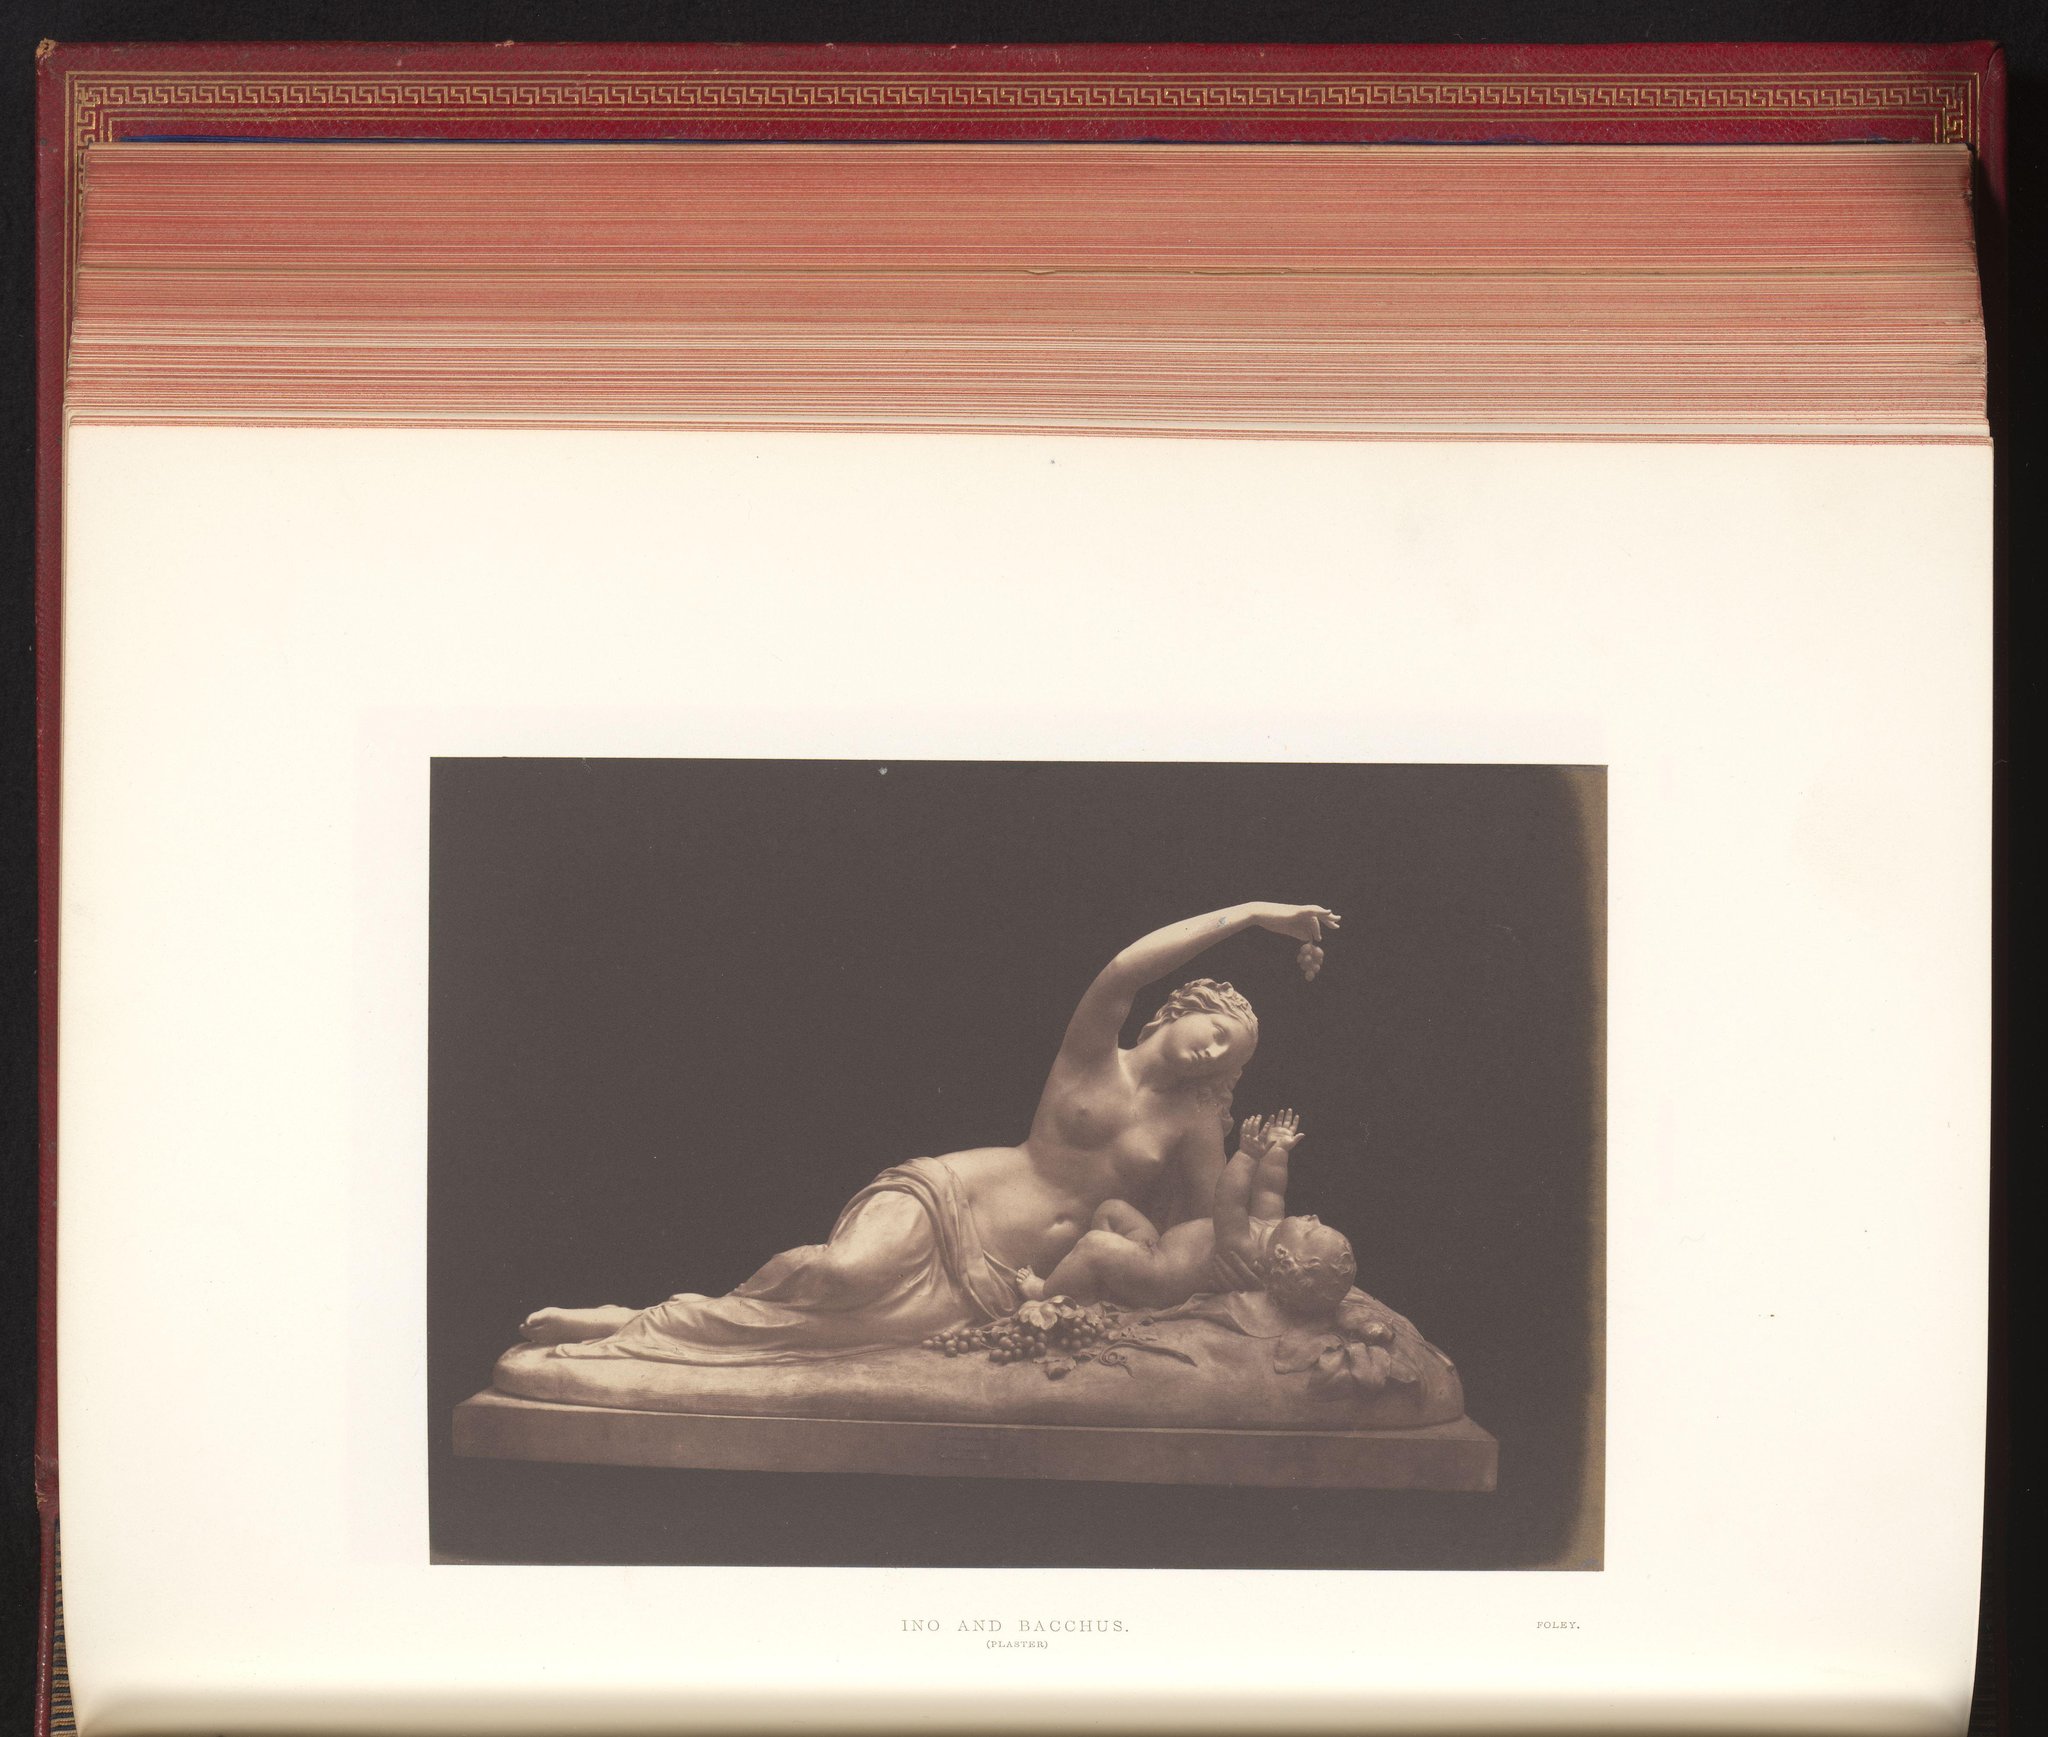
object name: photograph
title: Sculptuur door John Henry Foley, voorstellend Ino met Bacchus, tentoongesteld op de Great Exhibition of the Works of Industry of All Nations van 1851 in Londen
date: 1851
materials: photographic support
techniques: salted paper print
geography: london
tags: bacchus, possibly disguised as a girl, entrusted to the care of ino, piece of sculpture, reproduction of a piece of sculpture, london